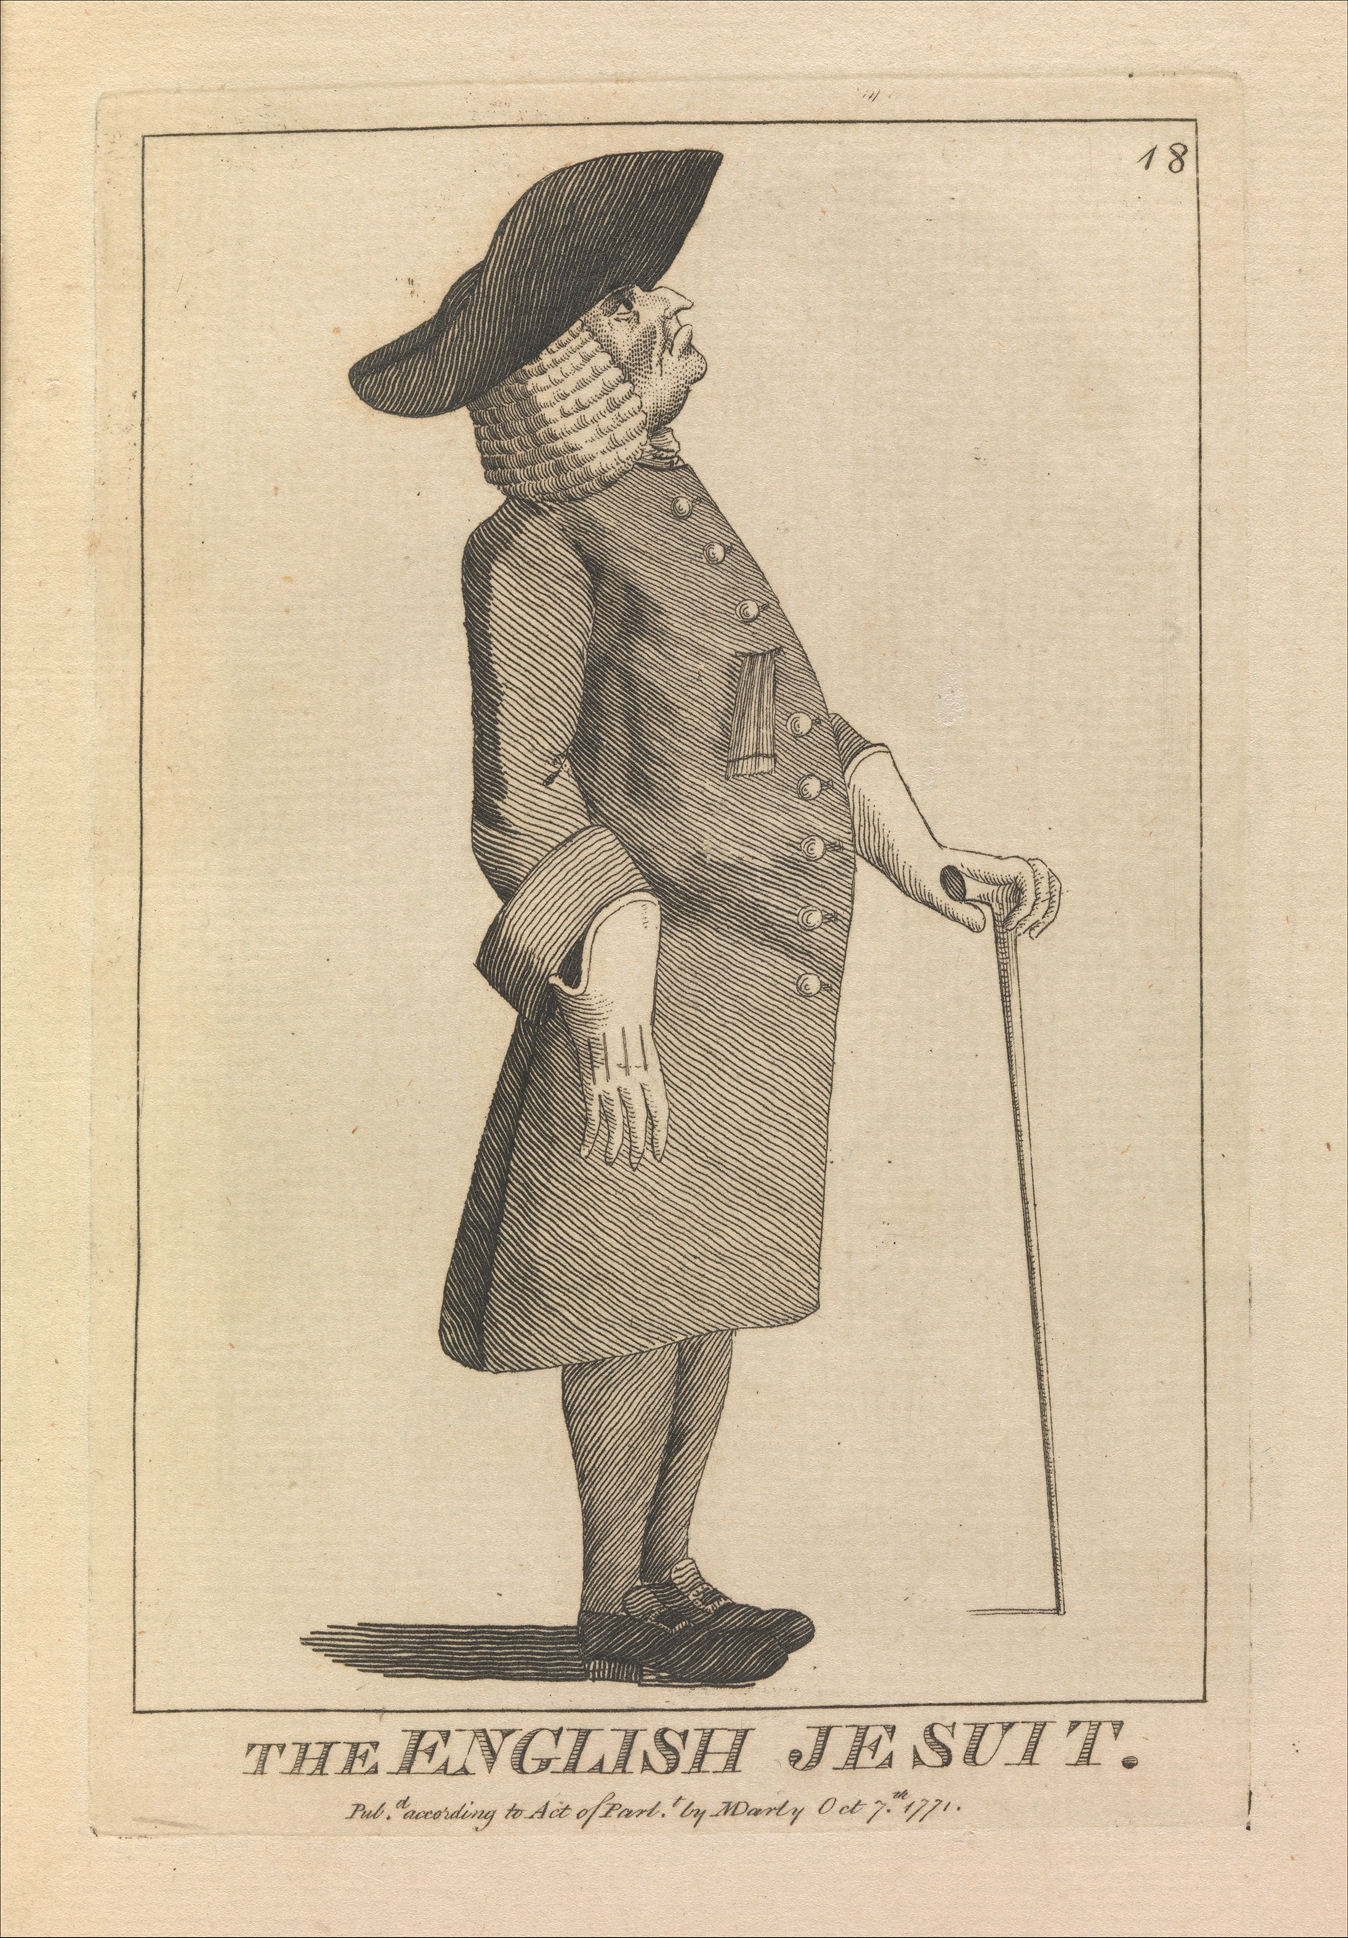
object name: print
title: The English Jesuit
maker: matthias darly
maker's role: publisher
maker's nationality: british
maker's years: 1720-1780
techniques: etching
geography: london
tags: men,profiles